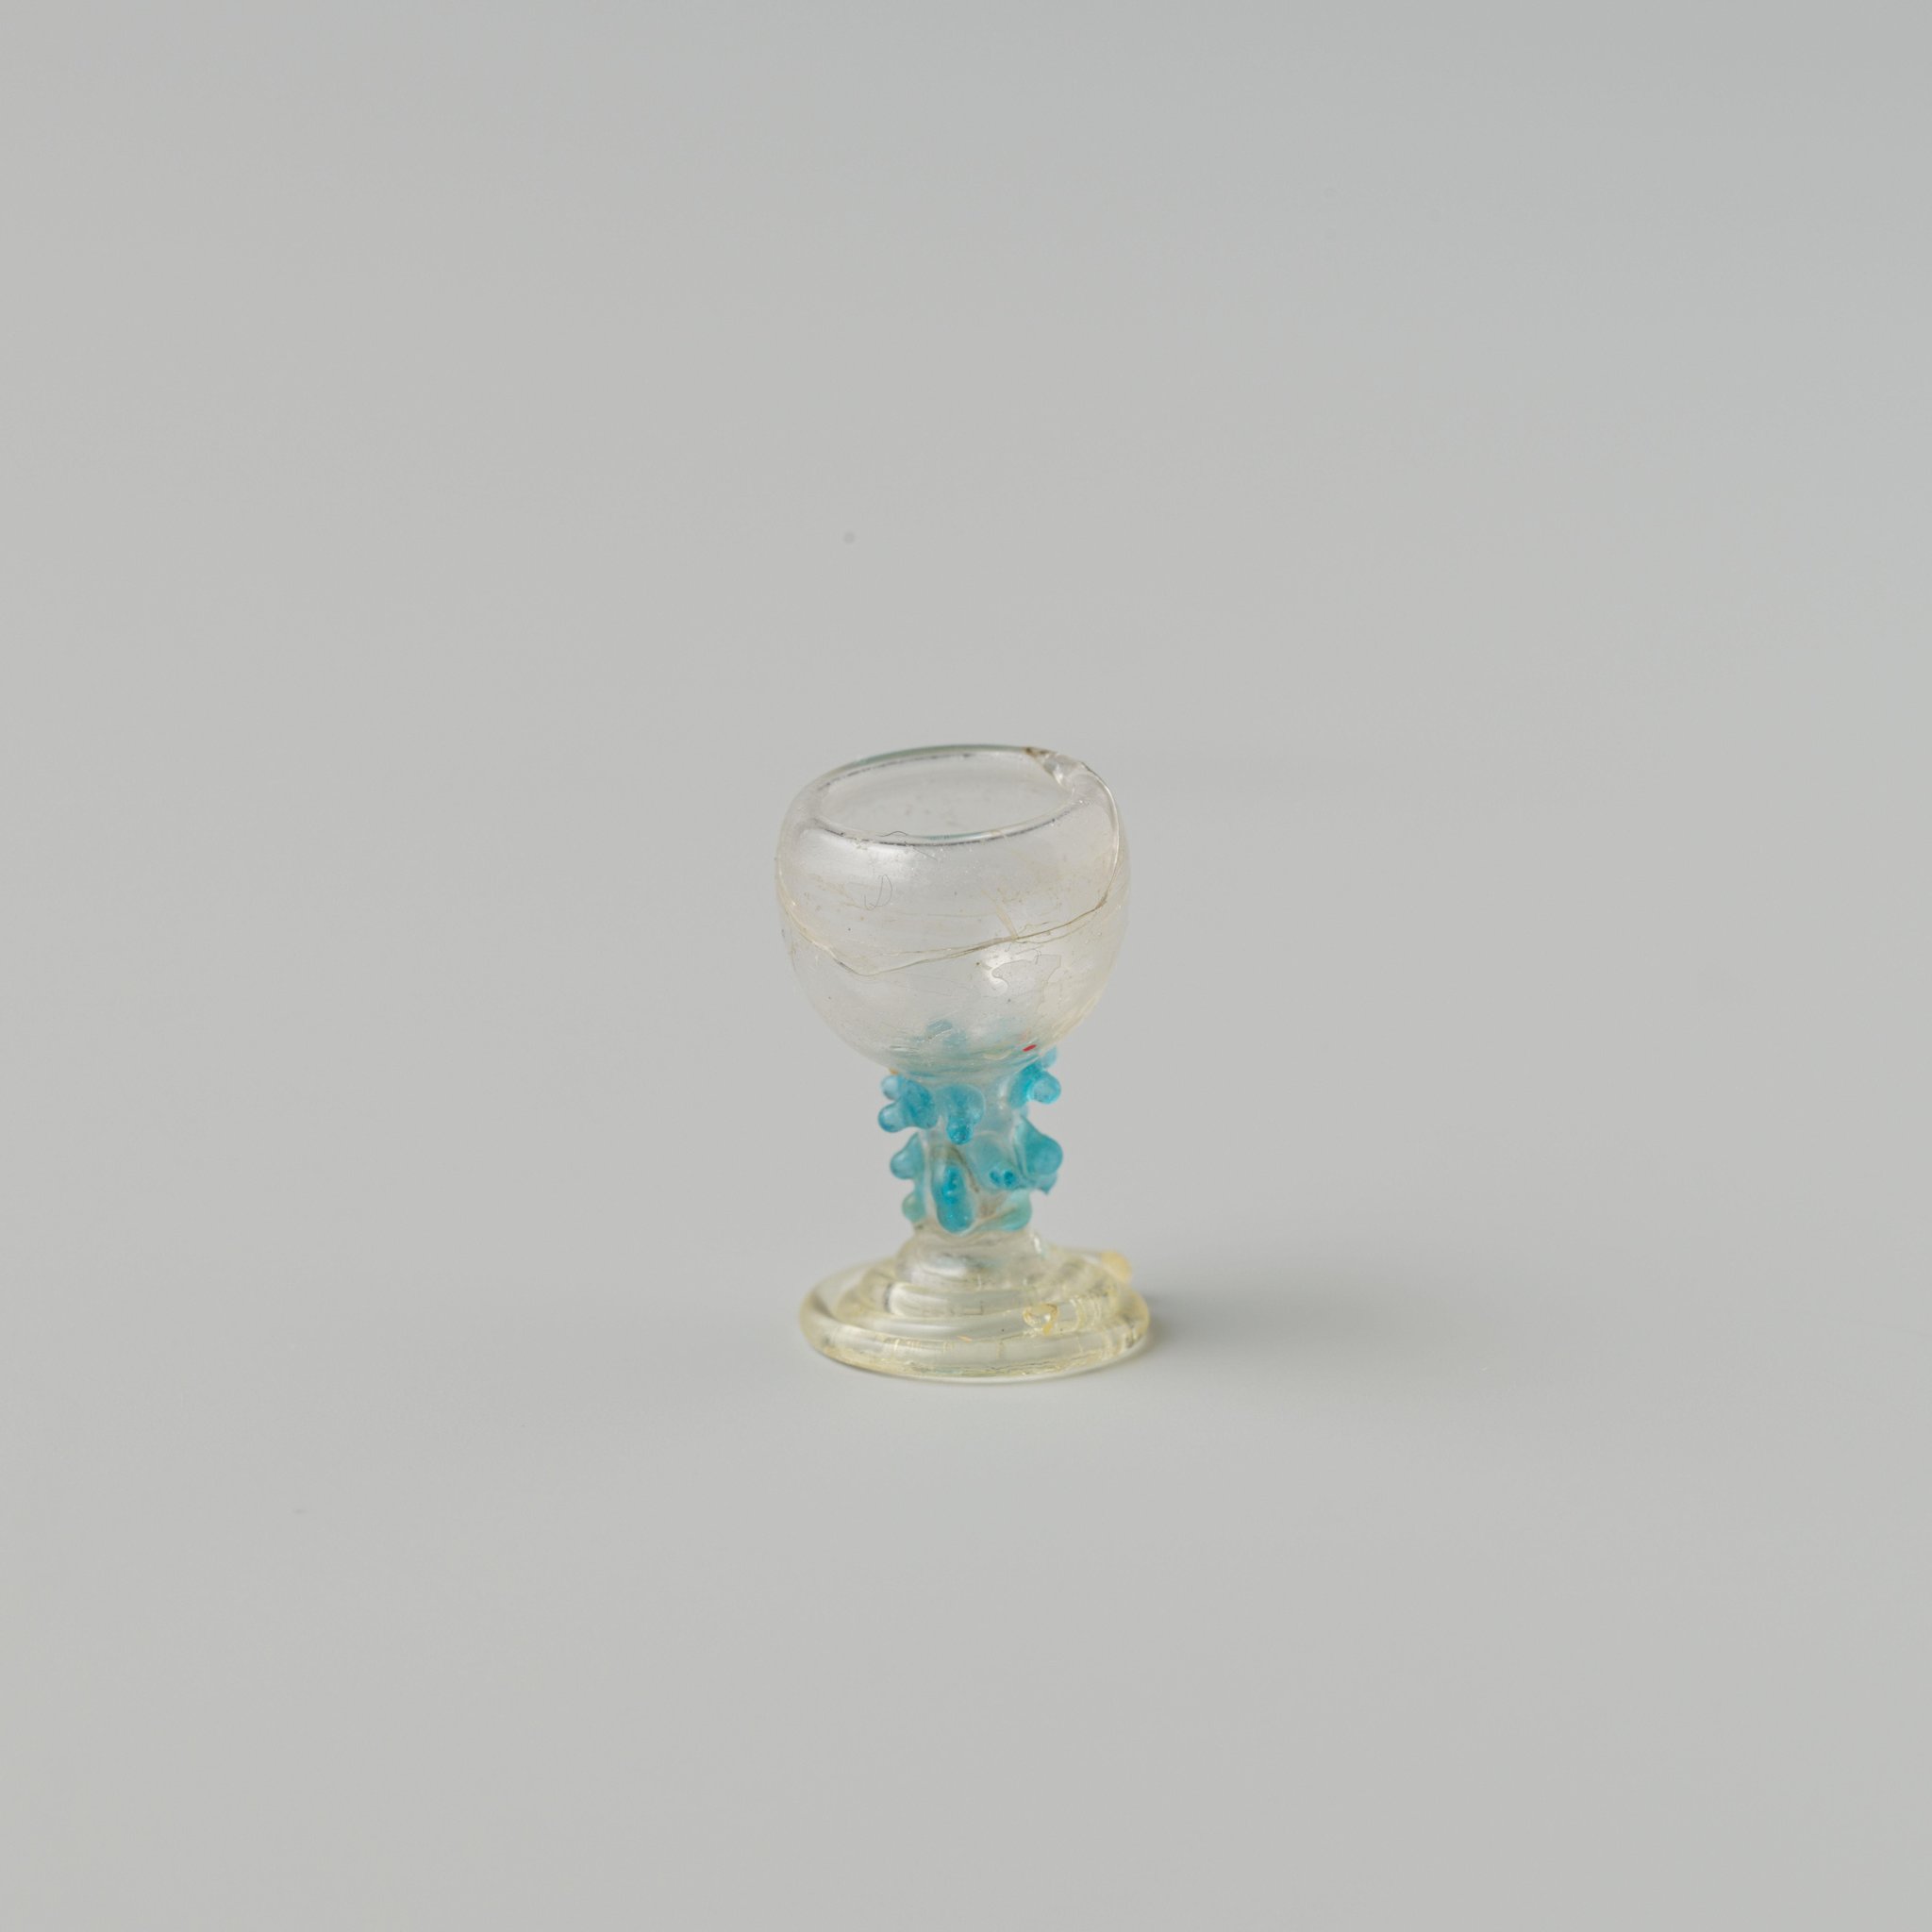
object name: roemer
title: Roemer van helder kleurloos glas met blauwe noppen op de schacht; cuppa dubbelwandig; voet van gespannen glasdraad.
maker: Anonymous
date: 1675-1710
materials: glass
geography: amsterdam